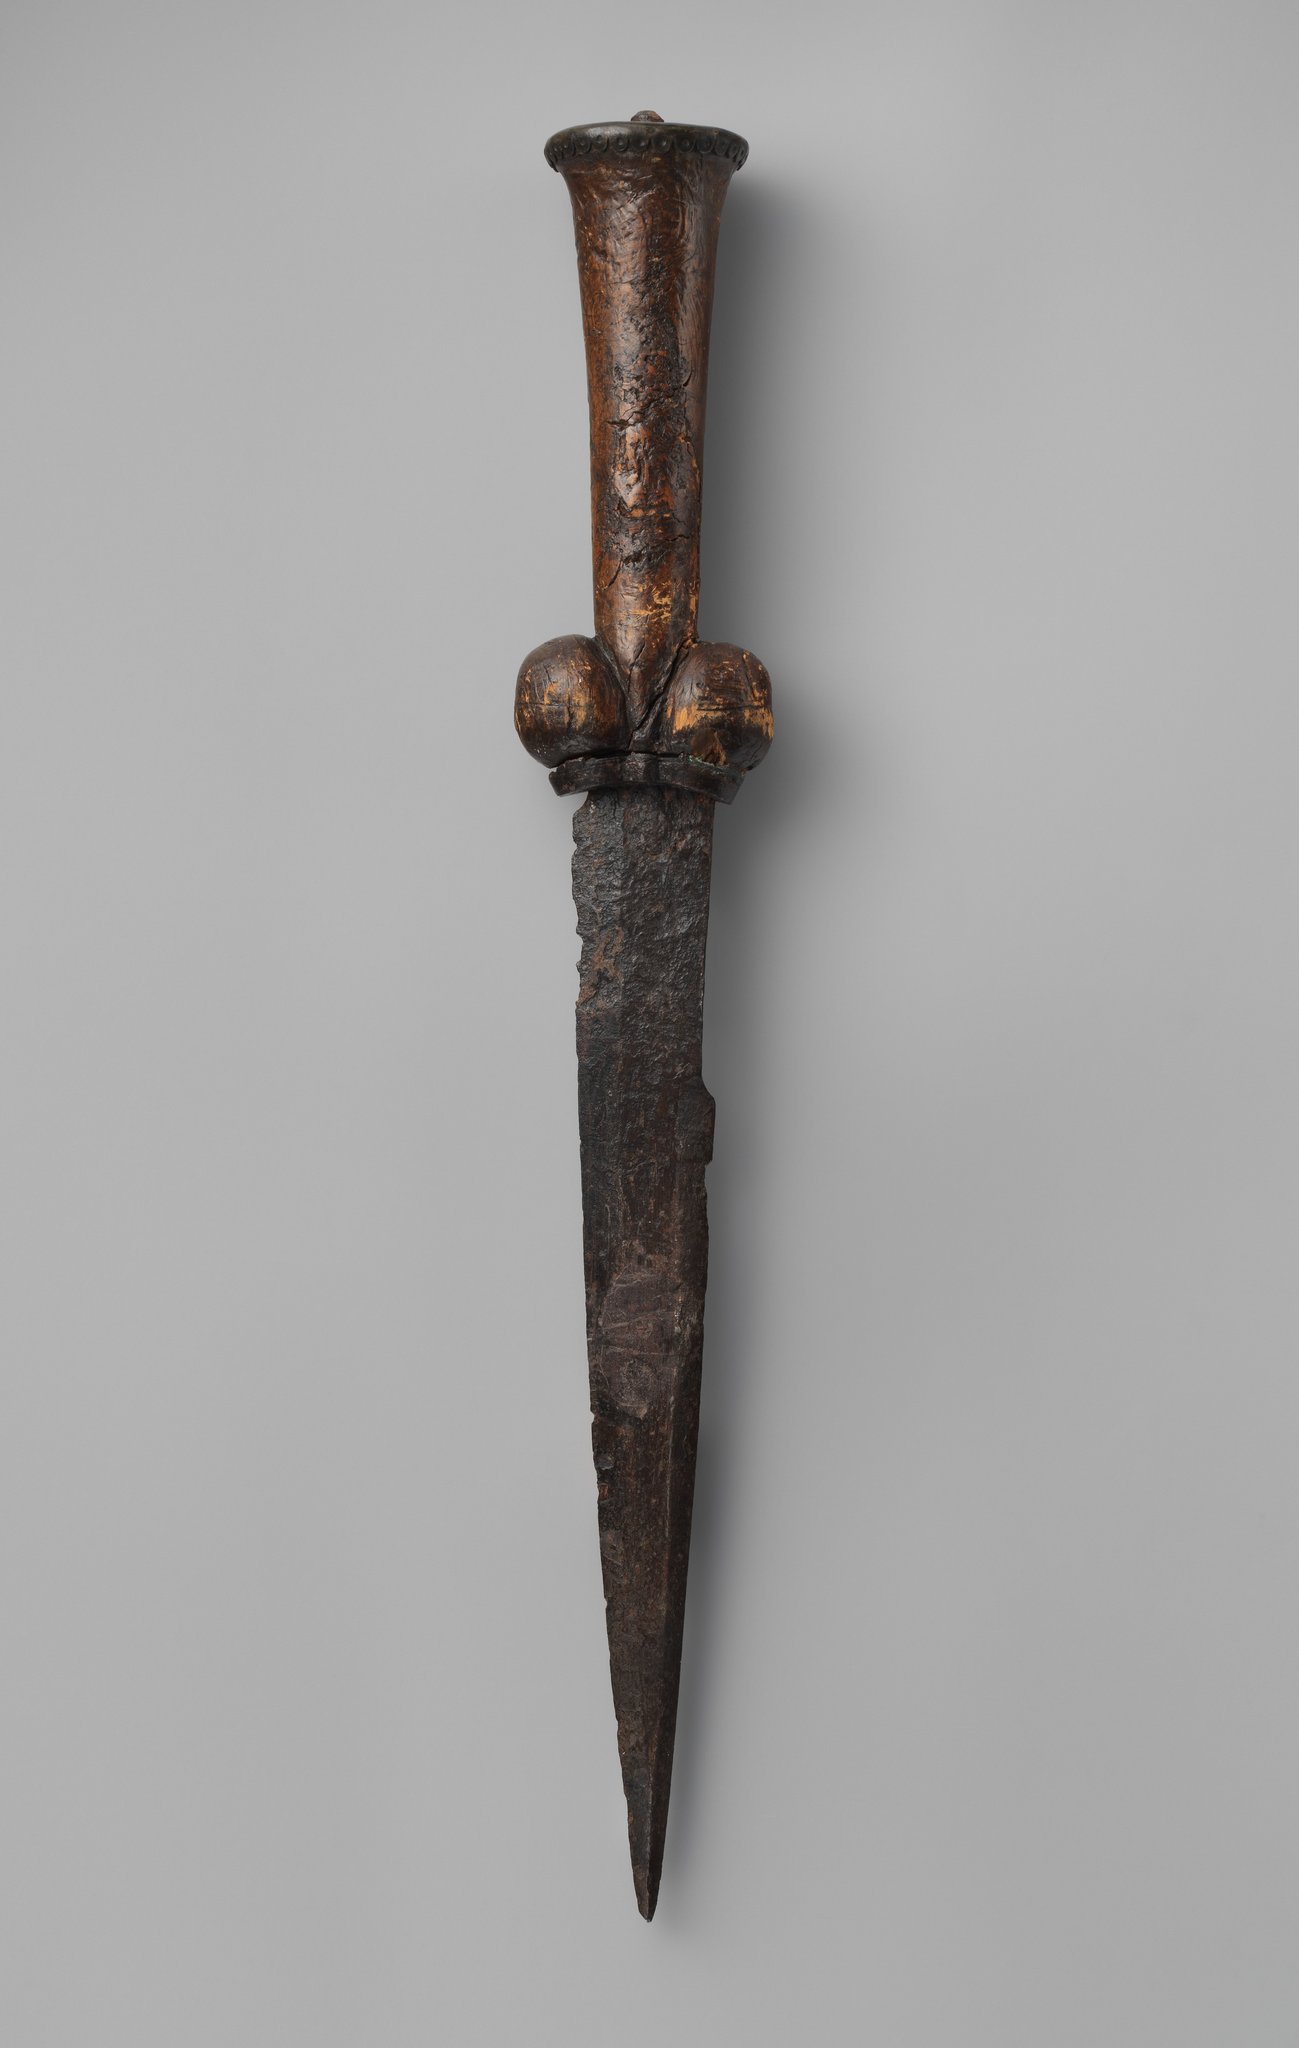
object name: ballock knife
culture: french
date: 1367-1400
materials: steel, wood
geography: france